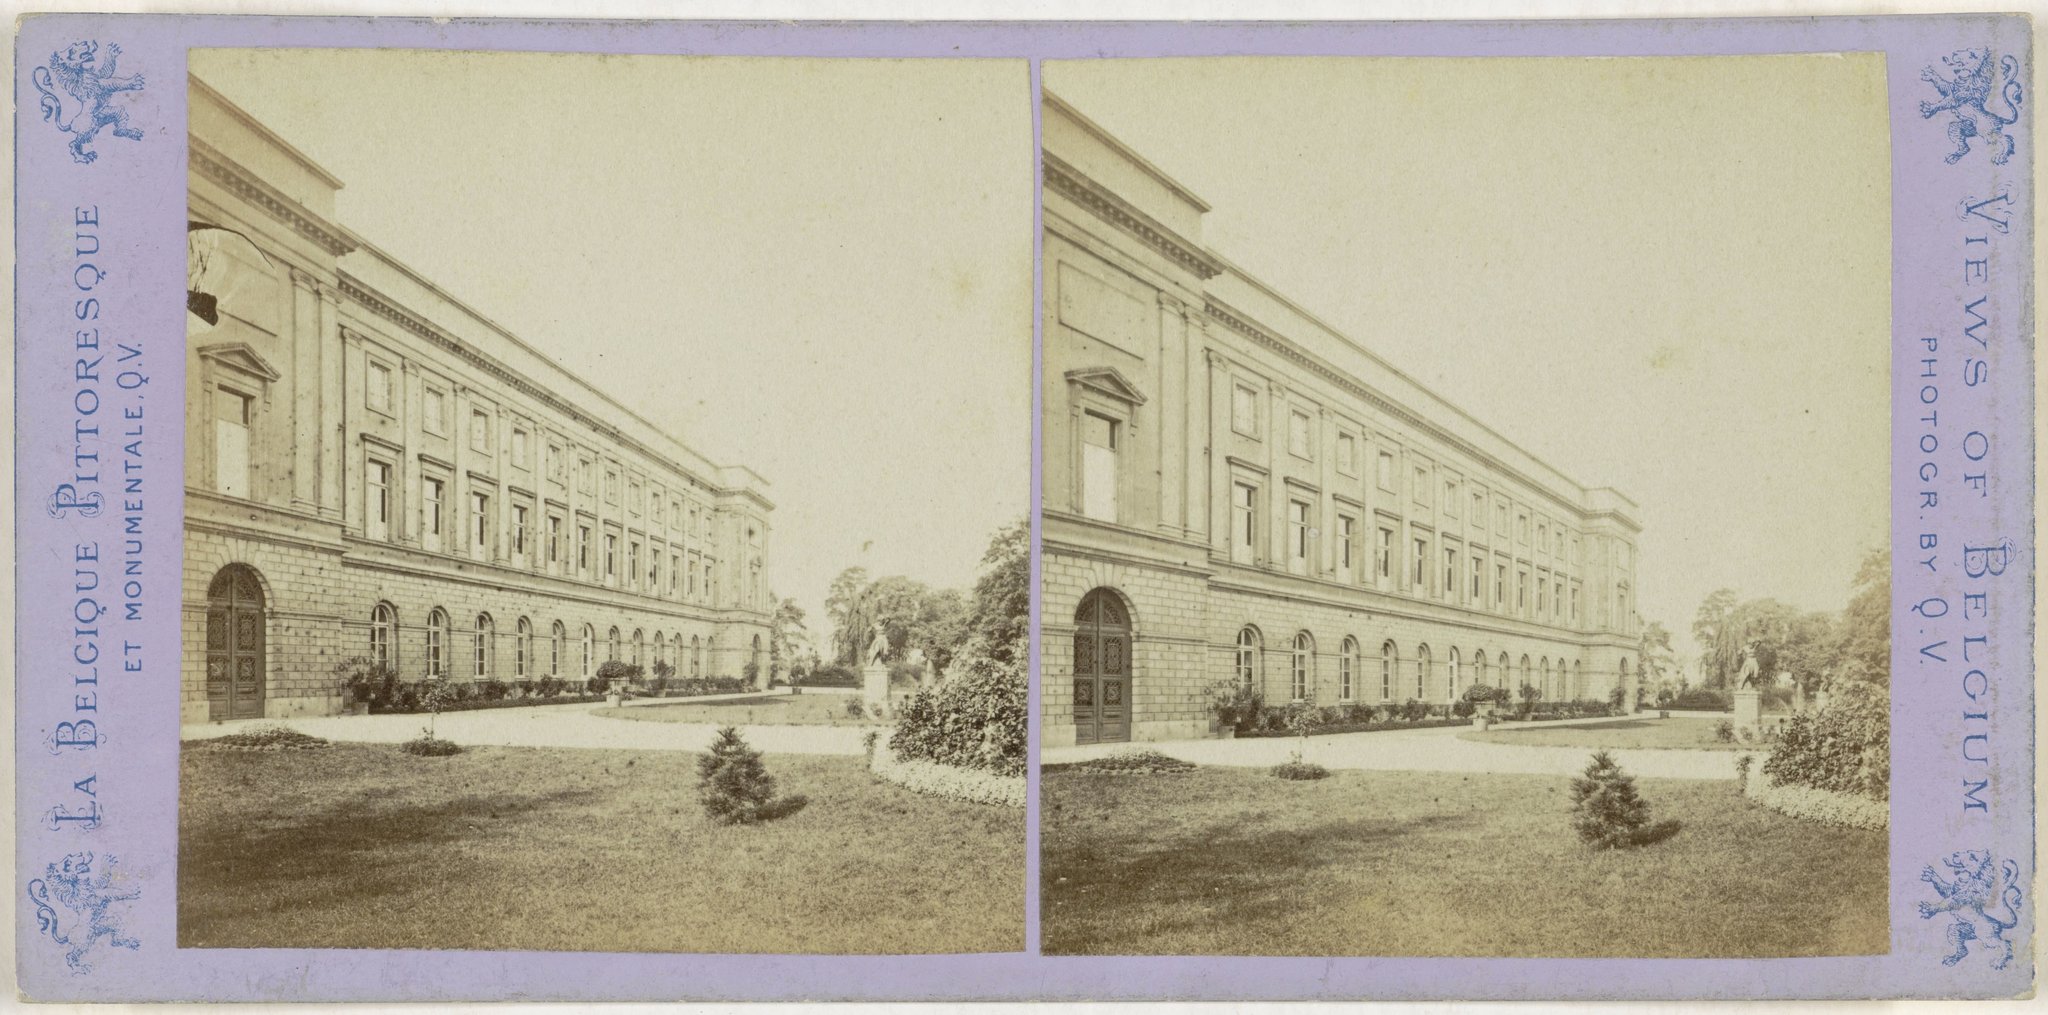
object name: stereograph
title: Bruxelles, le palais d'orange (palais du prince héréditaire)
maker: jules hippolyte quéval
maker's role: publisher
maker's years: 1824-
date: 1866-1870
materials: cardboard, paper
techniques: albumen print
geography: brussels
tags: palace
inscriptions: number: ‘No 1624’